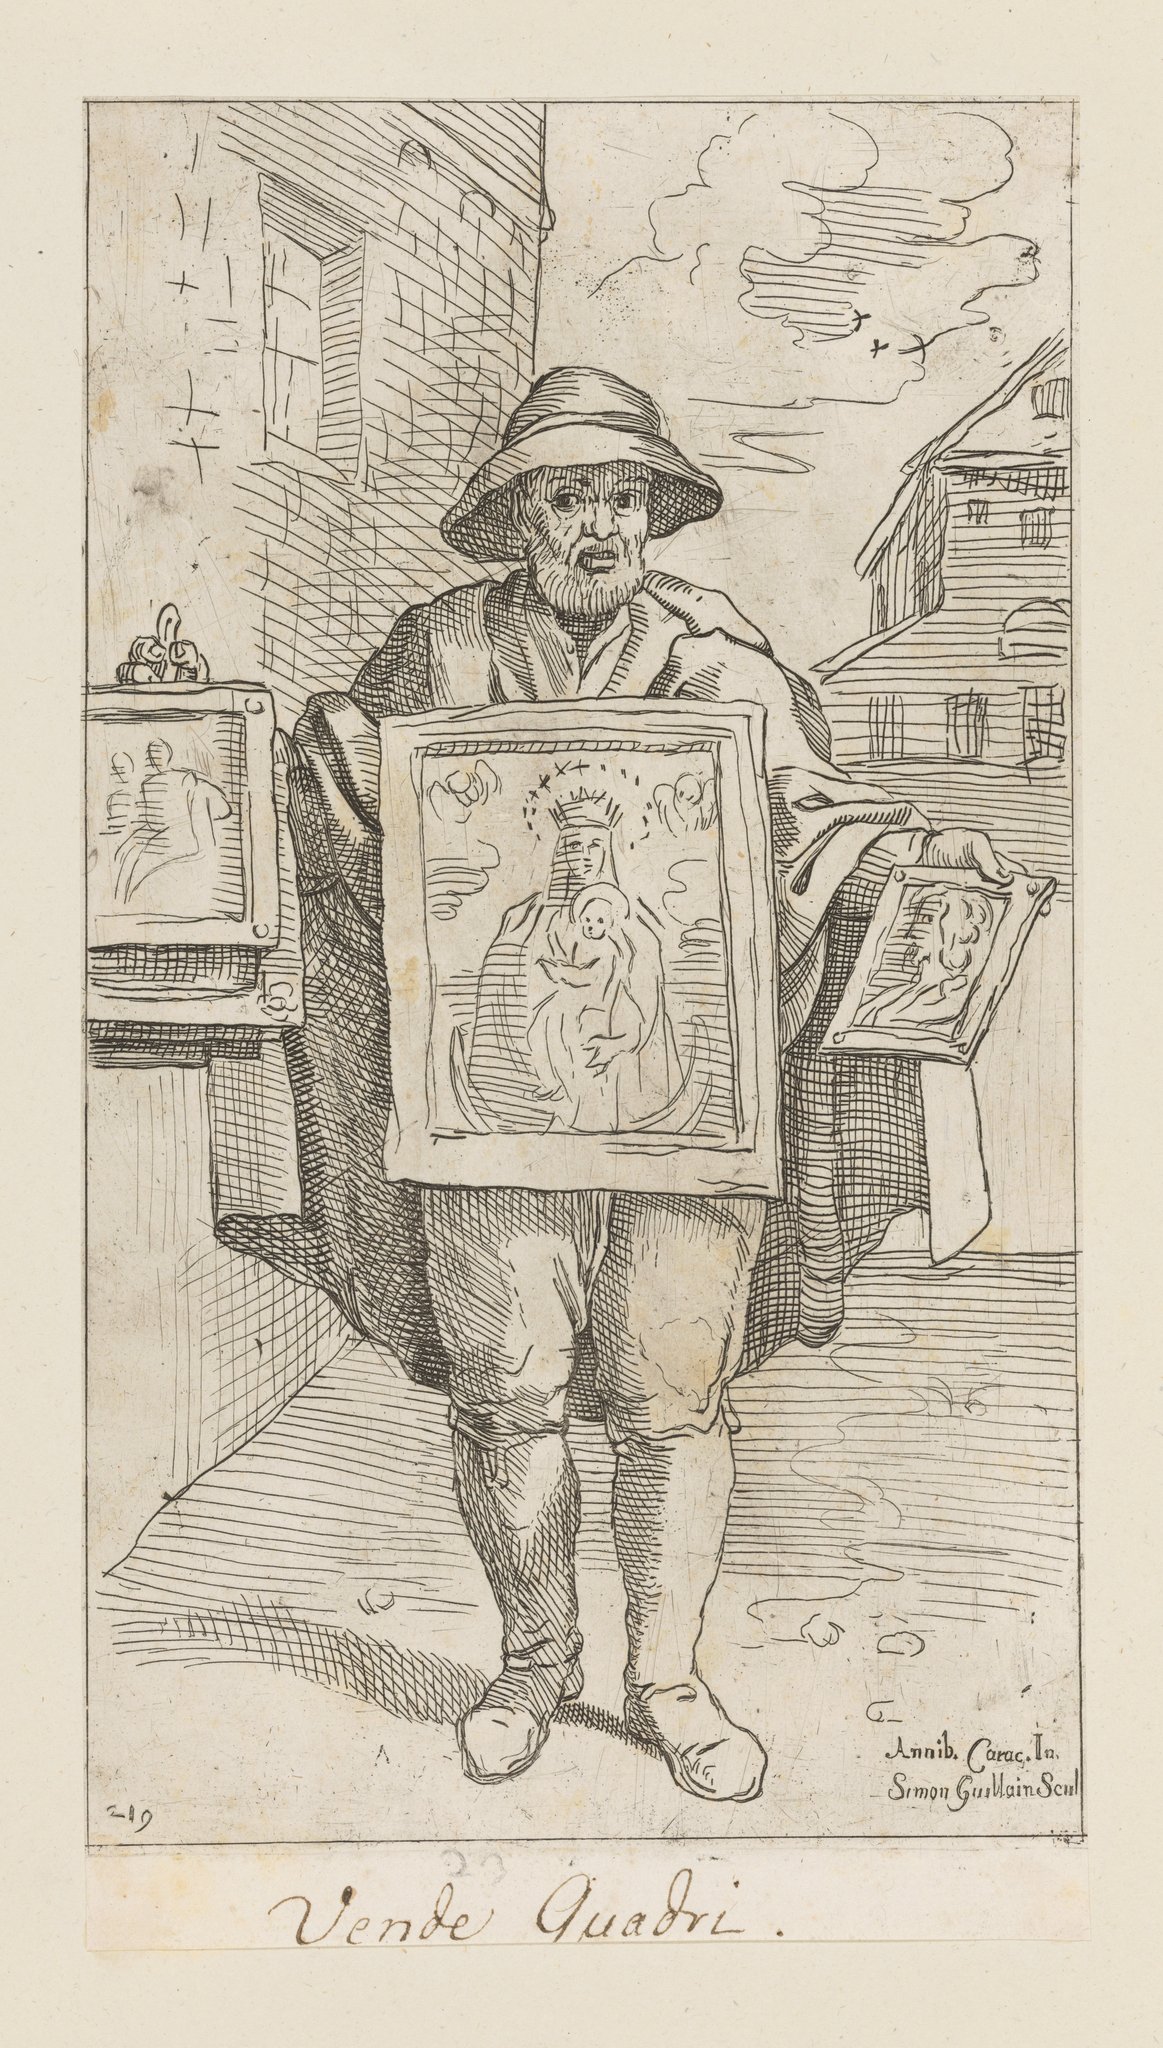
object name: print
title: Plate 19: Vendor of holy pictures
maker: simon guillain ii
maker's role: artist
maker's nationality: french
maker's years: 1618-1718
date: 1646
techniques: etching